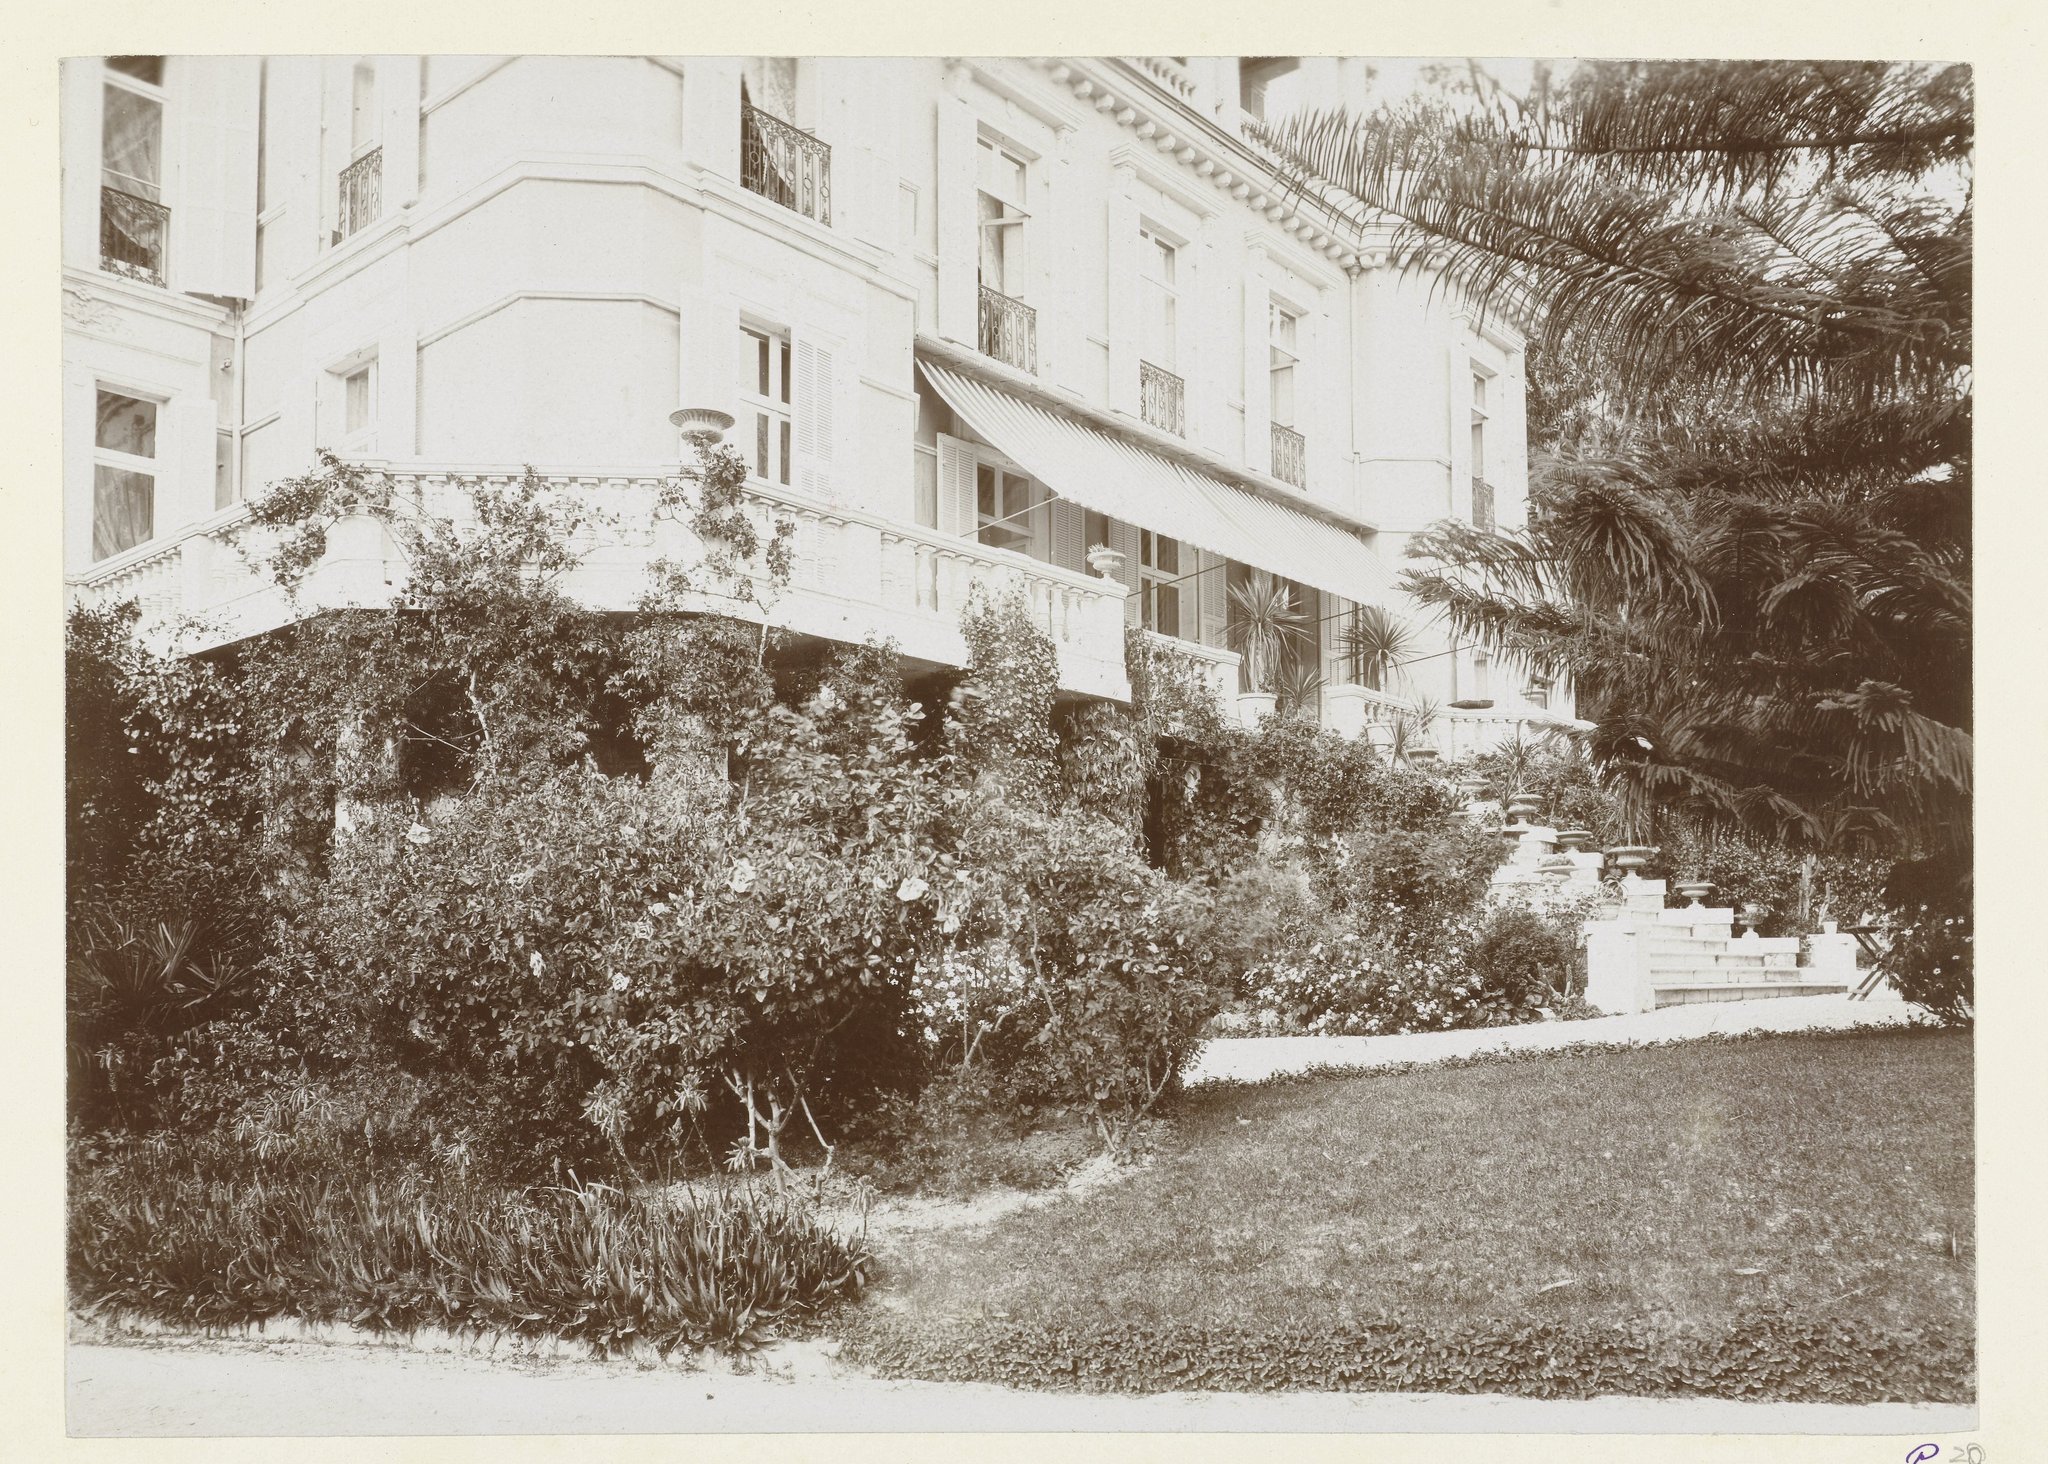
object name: photograph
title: Onderste verdieping en de tuin van het huis Villa Louise in Menton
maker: henry pauw van wieldrecht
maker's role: fotograaf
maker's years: 1863-1912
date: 1886-1896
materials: cardboard, photographic support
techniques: albumen print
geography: france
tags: menton